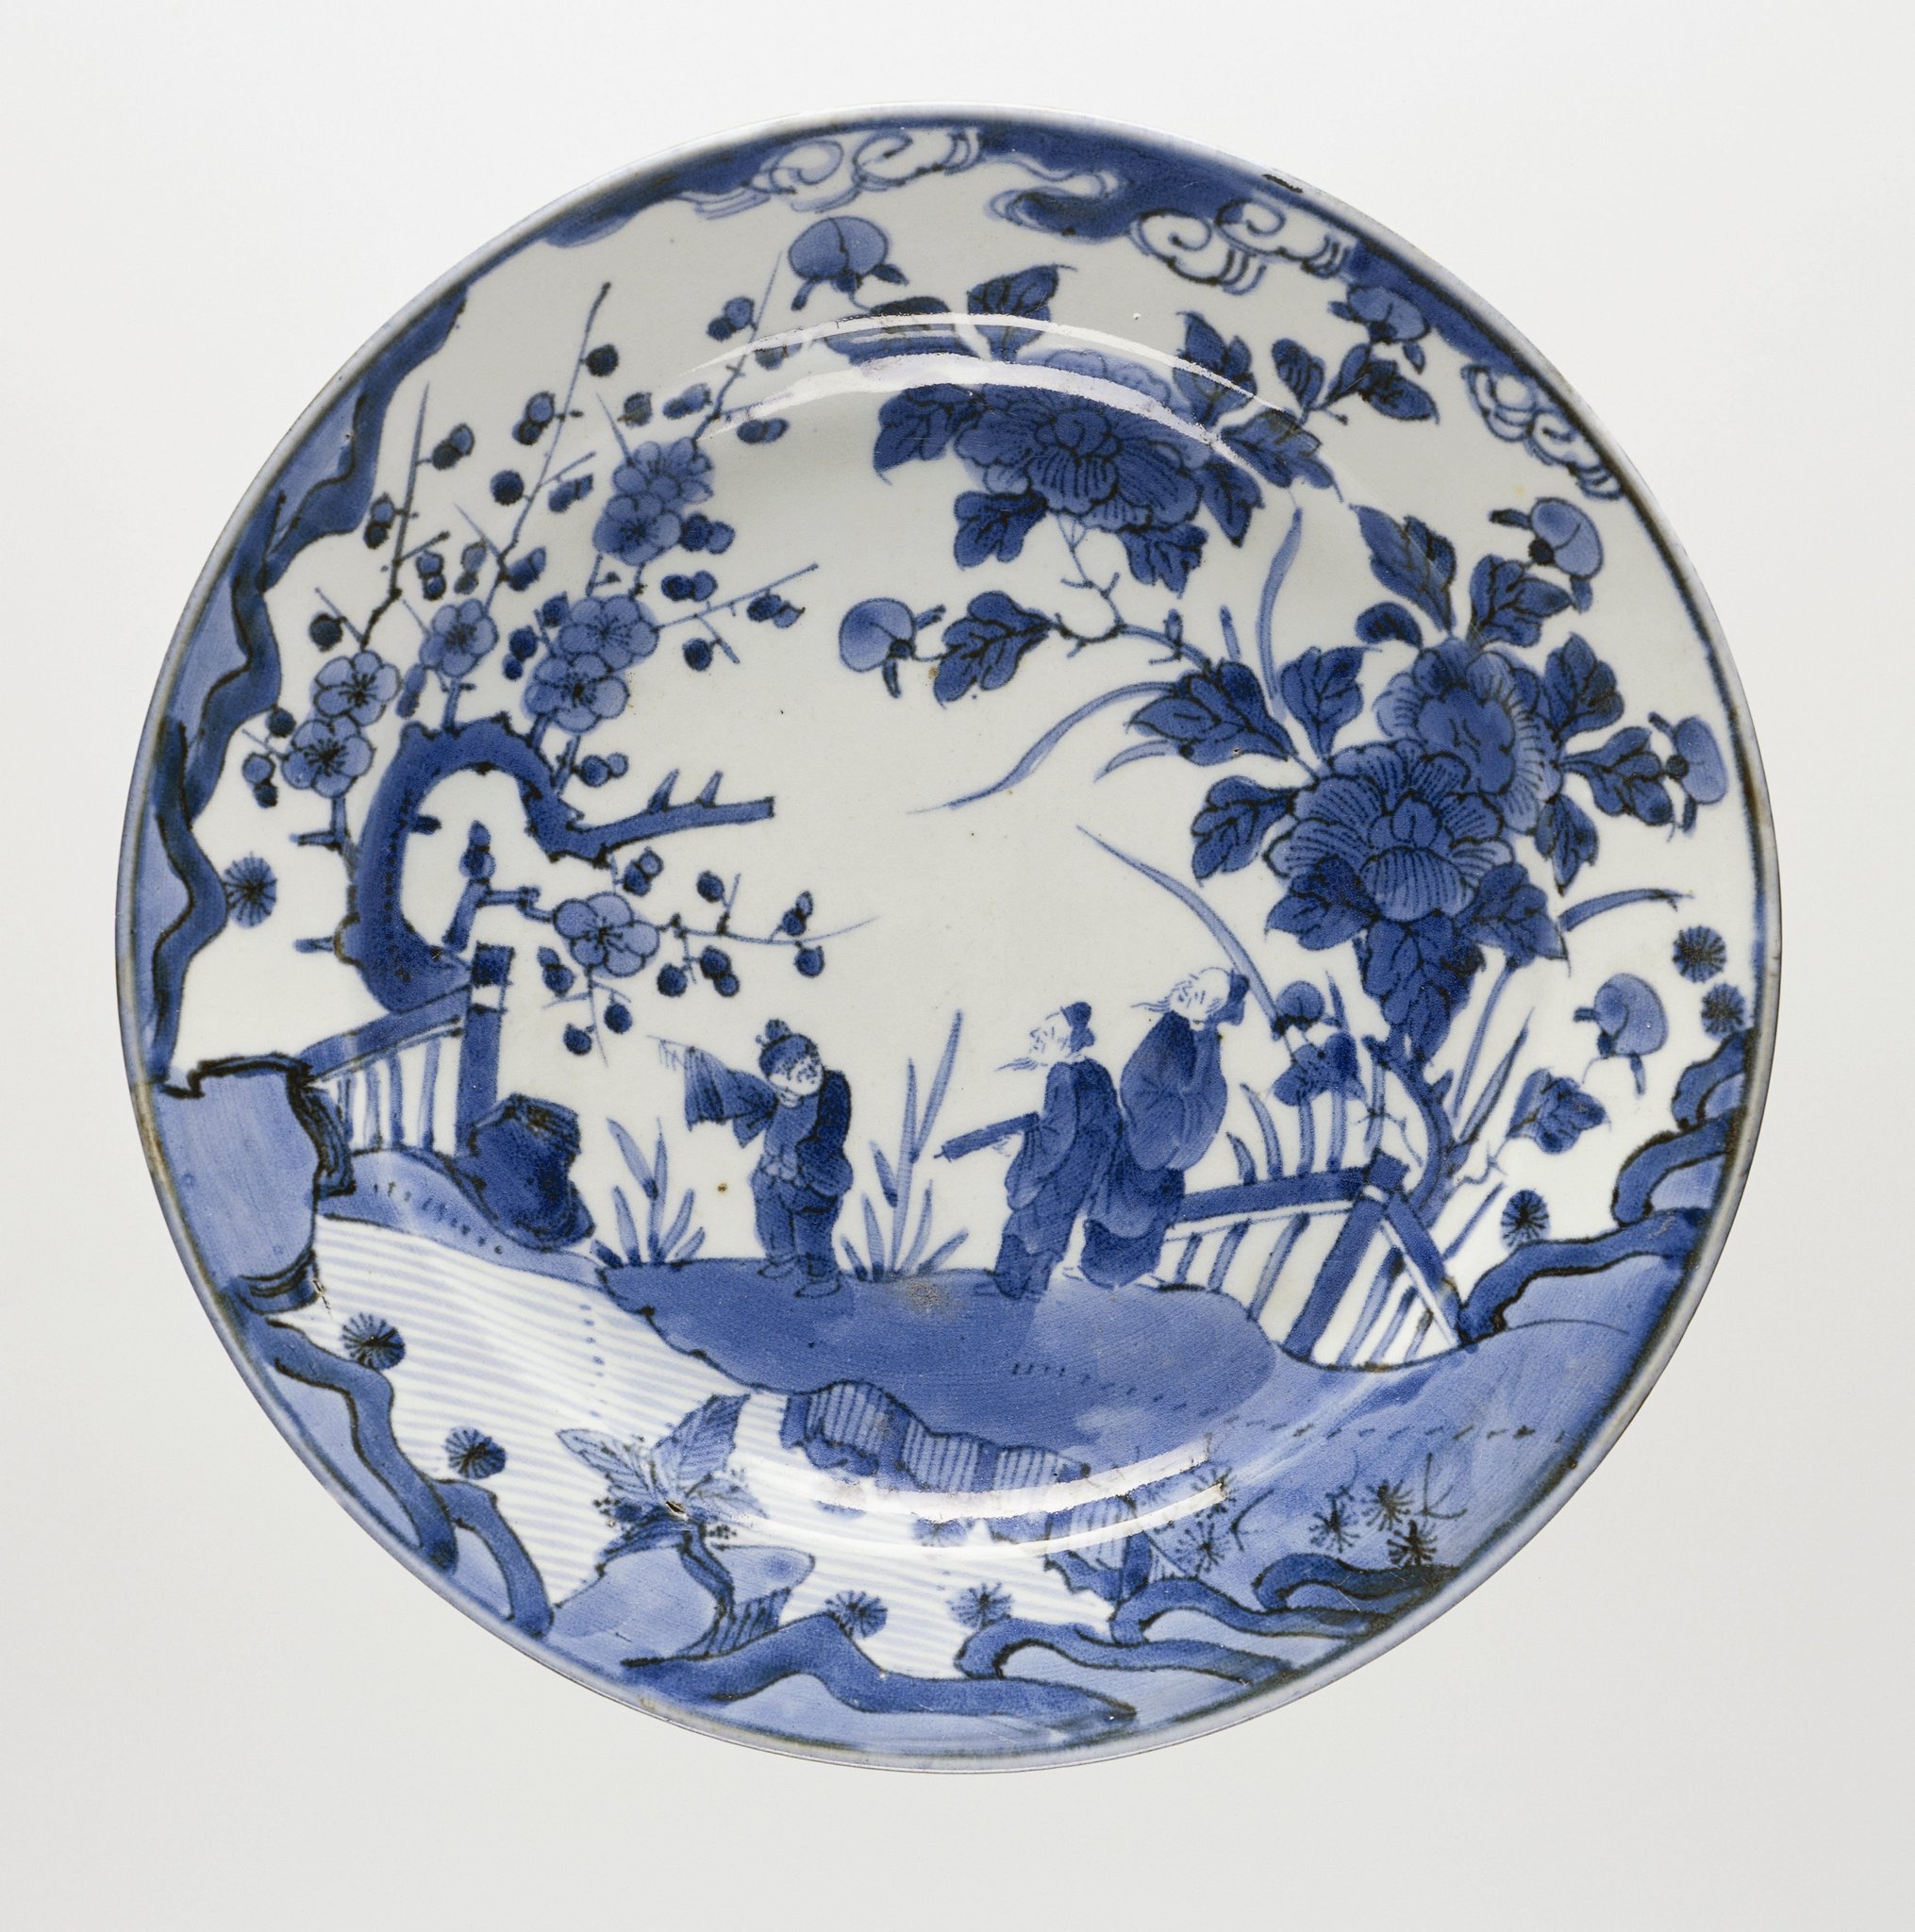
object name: platter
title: Dish with three figures in a water landscape with flowering plants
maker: Anonymous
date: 1675-1725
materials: cobalt, glaze, paint, porcelain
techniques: firing, turning, vitrification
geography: japan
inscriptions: label: ‘P[?] 8031/ Imari/ +- 1700/ f 475’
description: Schotel van porselein, beschilderd in onderglazuur blauw. Op de voorzijde een doorlopende voorstelling van drie personen in een landschap bij de oever van een rivier. Één man heeft een rol in zijn hand, een ander staat dicht bij het water en wijst naar de overzijde. Rechts van de groep een grote pioenplant achter een hekje; links een prunusboom achter een hek. Vijf proenen op de onderzijde. Oud label op de onderzijde met 'P[?] 8031/ Imari/ +- 1700/ f 475'. Arita, blauw-wit.